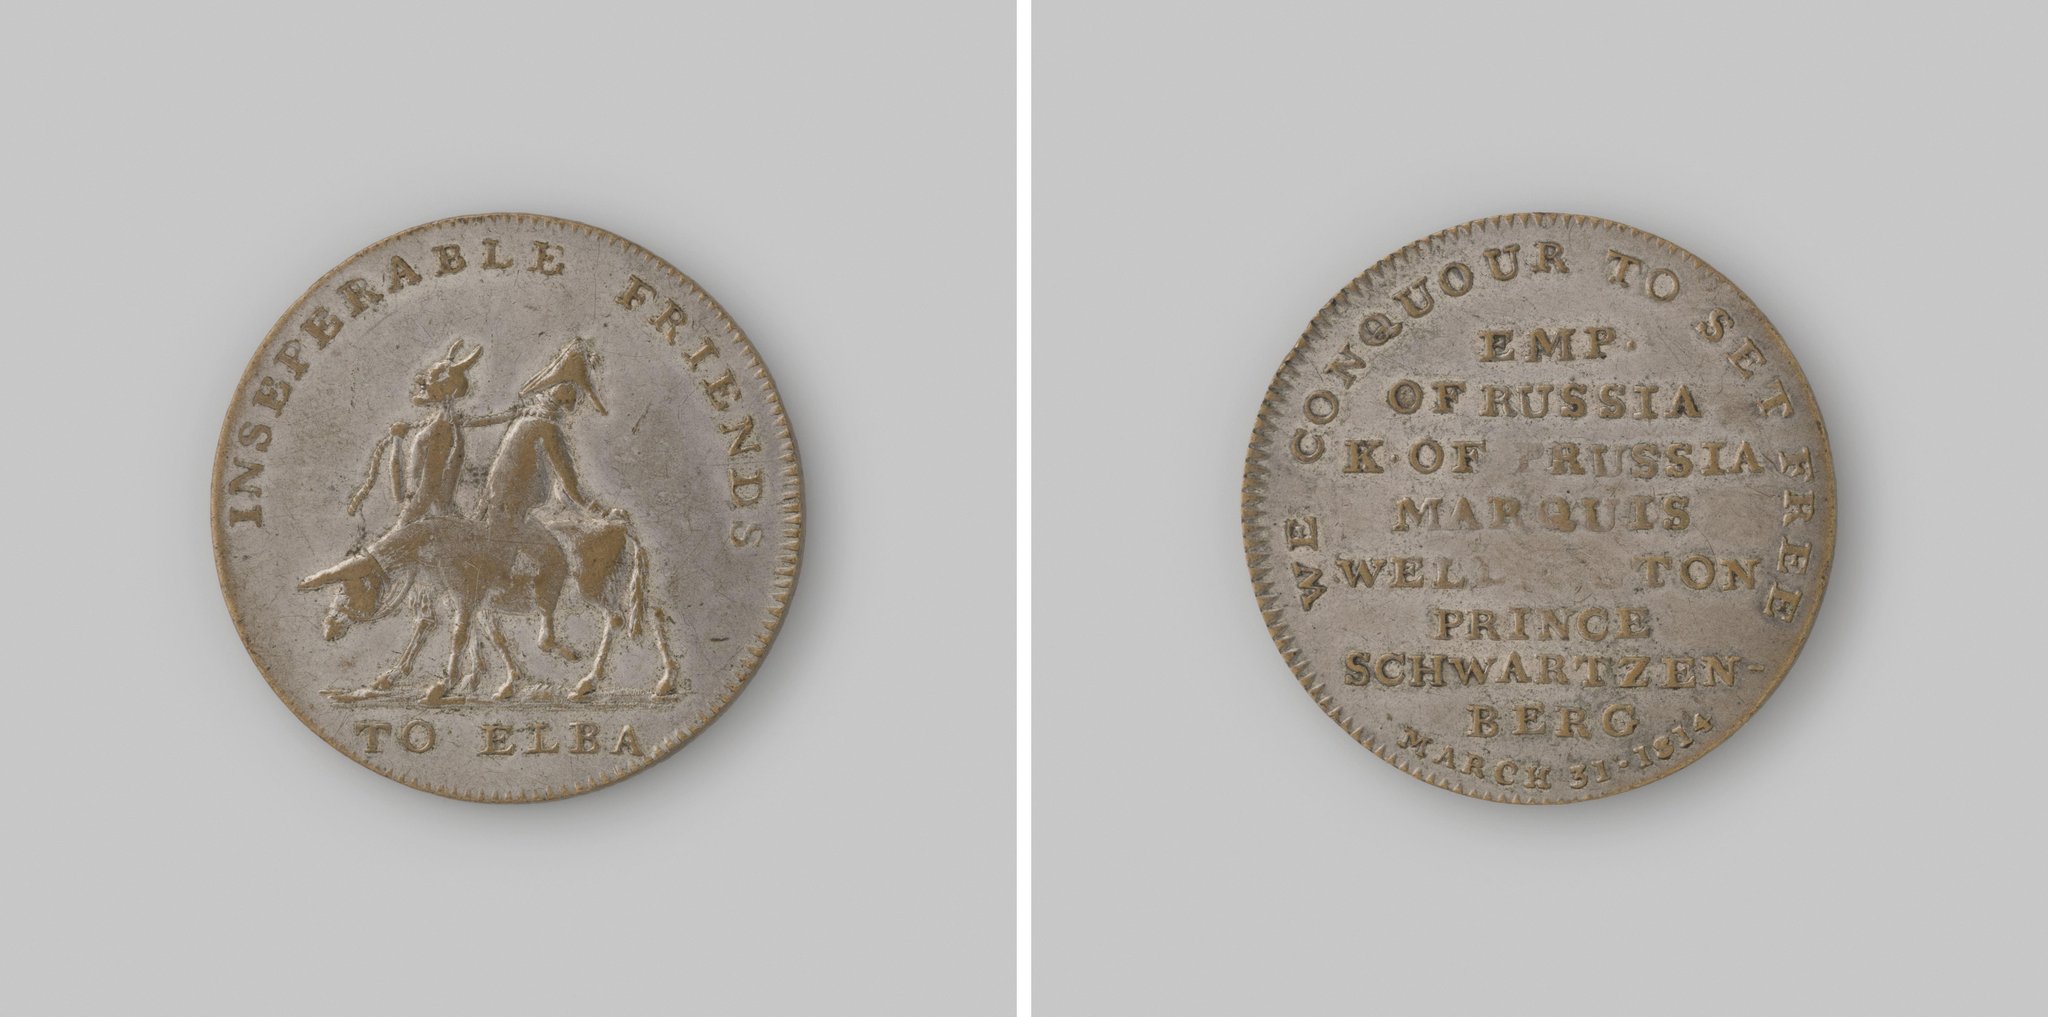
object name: history medal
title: Spotpenning op de verbanning van Napoleon naar Elba 1814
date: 1814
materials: brass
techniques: striking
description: Verzilverde penning, op de voorzijde Satan die Napoleon, achterstevoren op een ezel zittend, wegleidt, met omschrift en afsnedetekst, op de keerzijde acht regels tekst met omschrift.